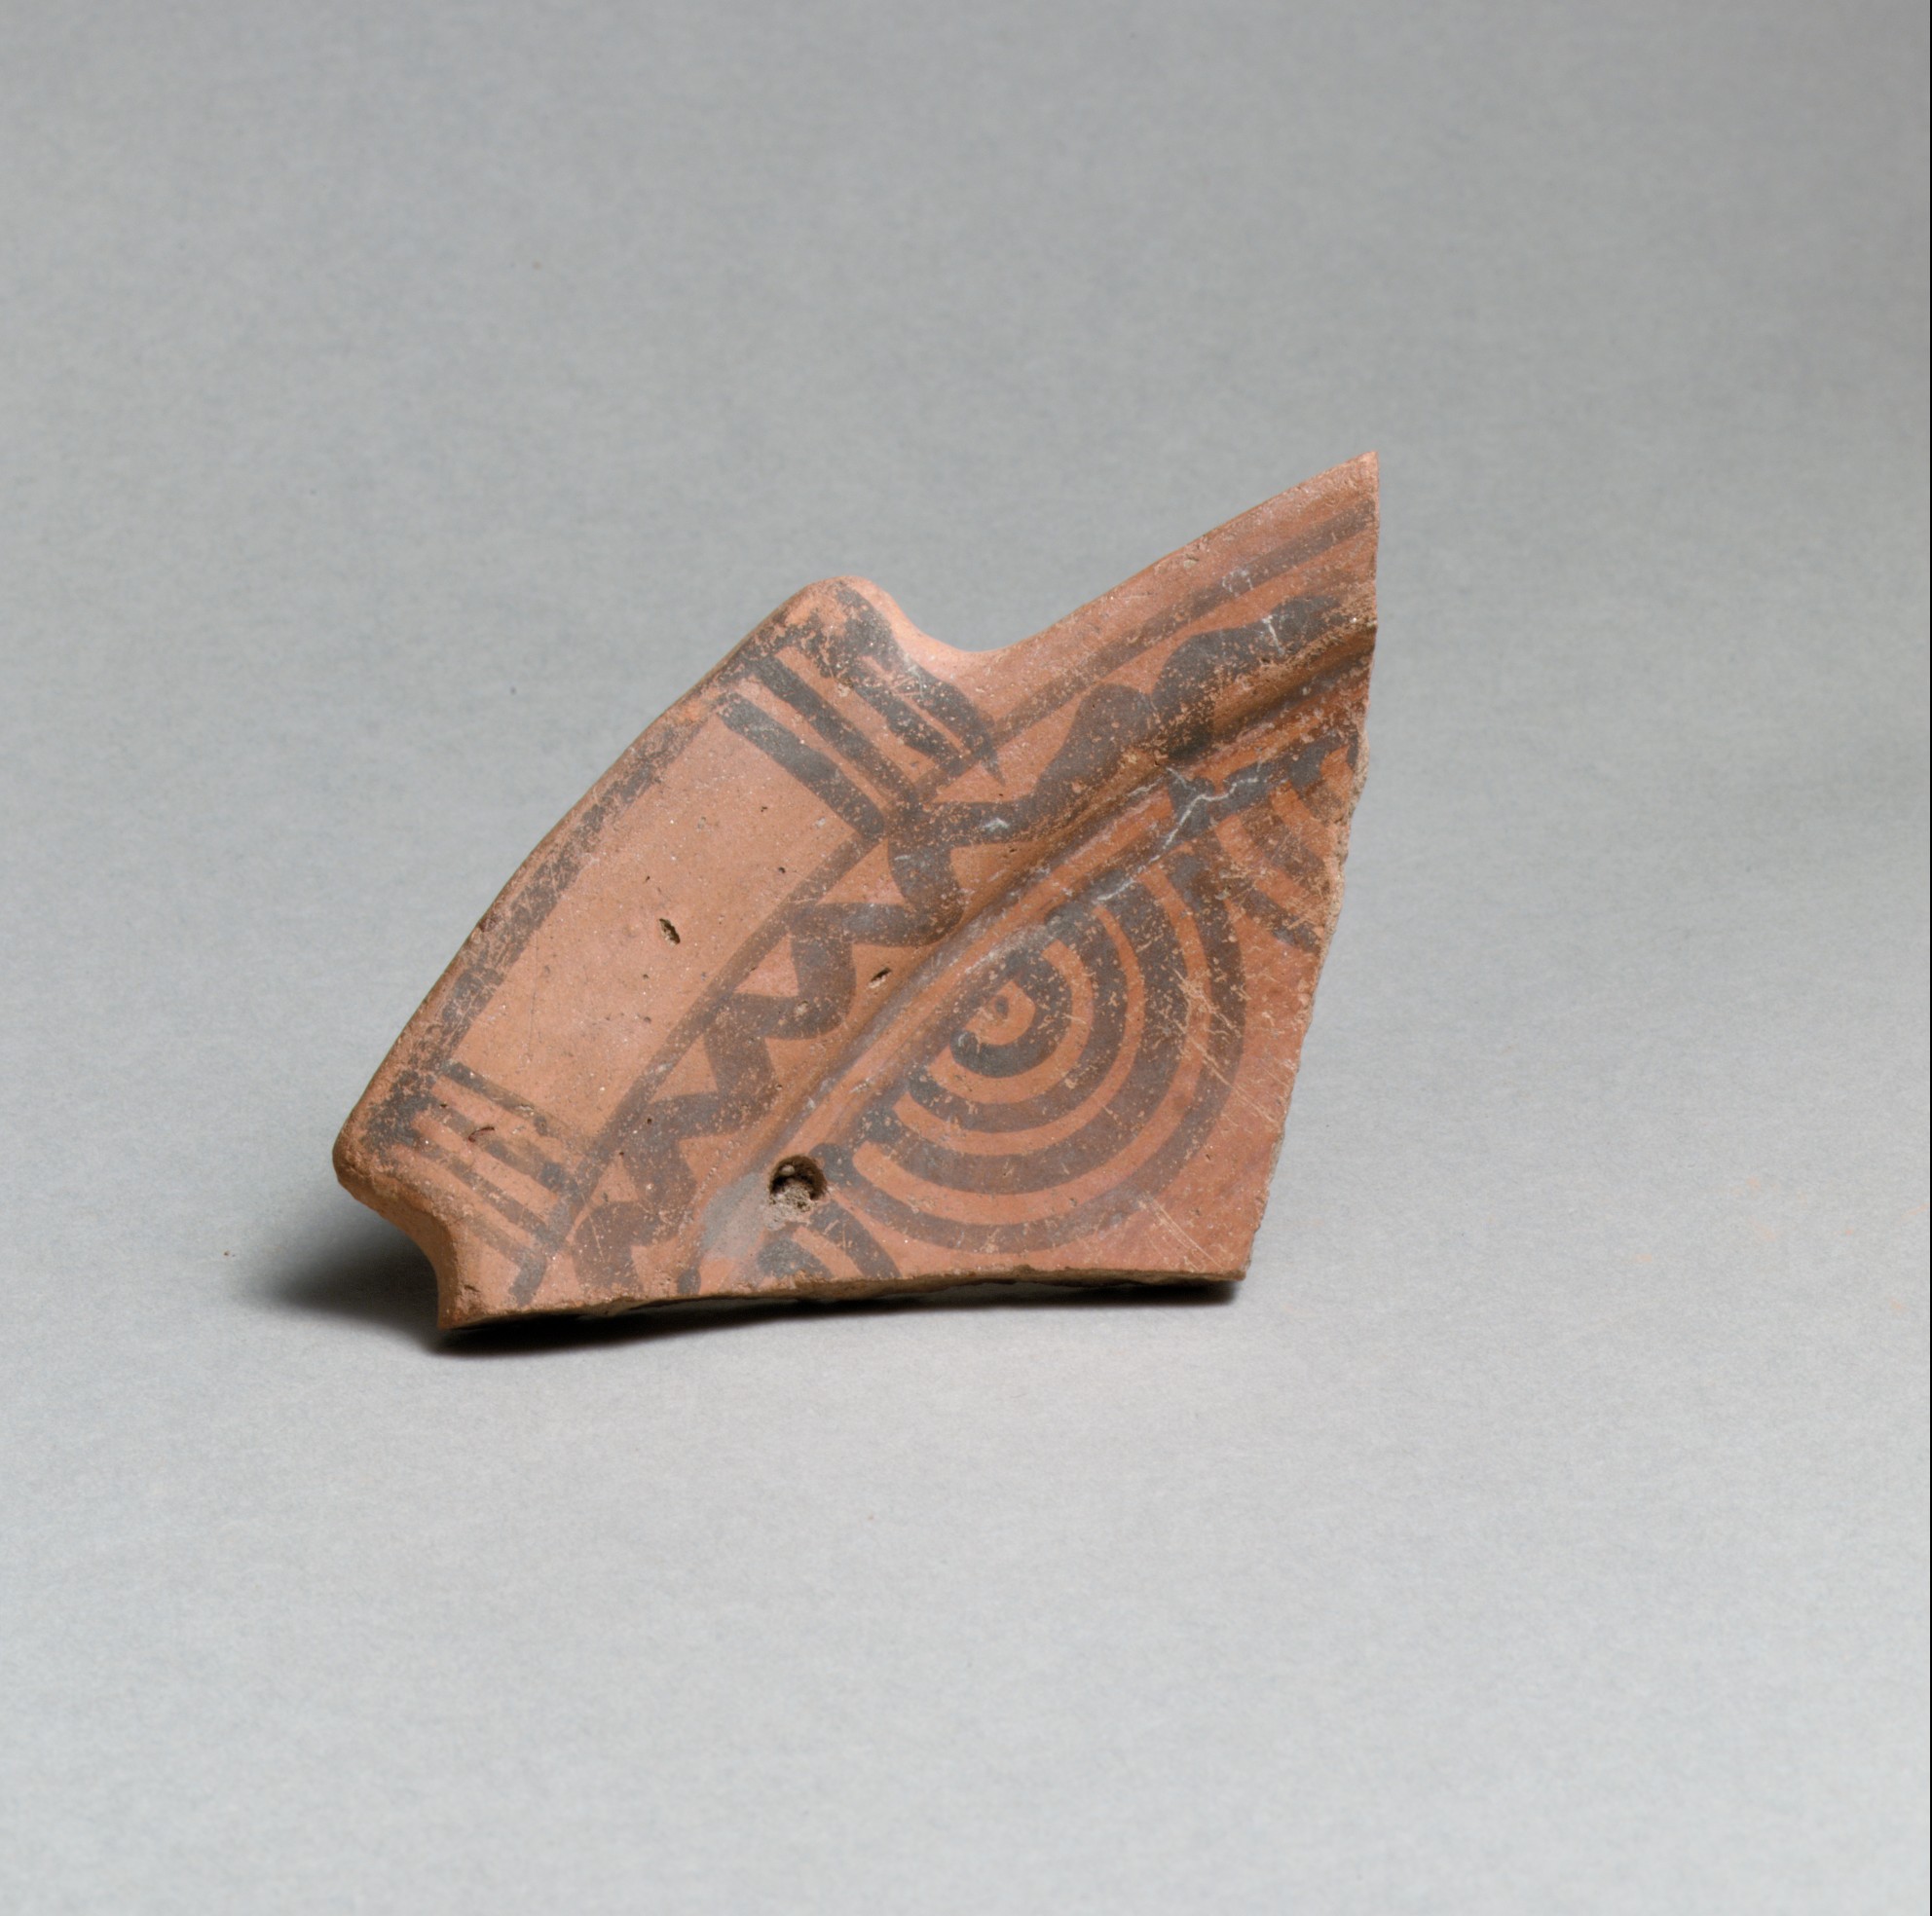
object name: vase fragment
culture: greek or lydian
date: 1050-700 BCE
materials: terracotta